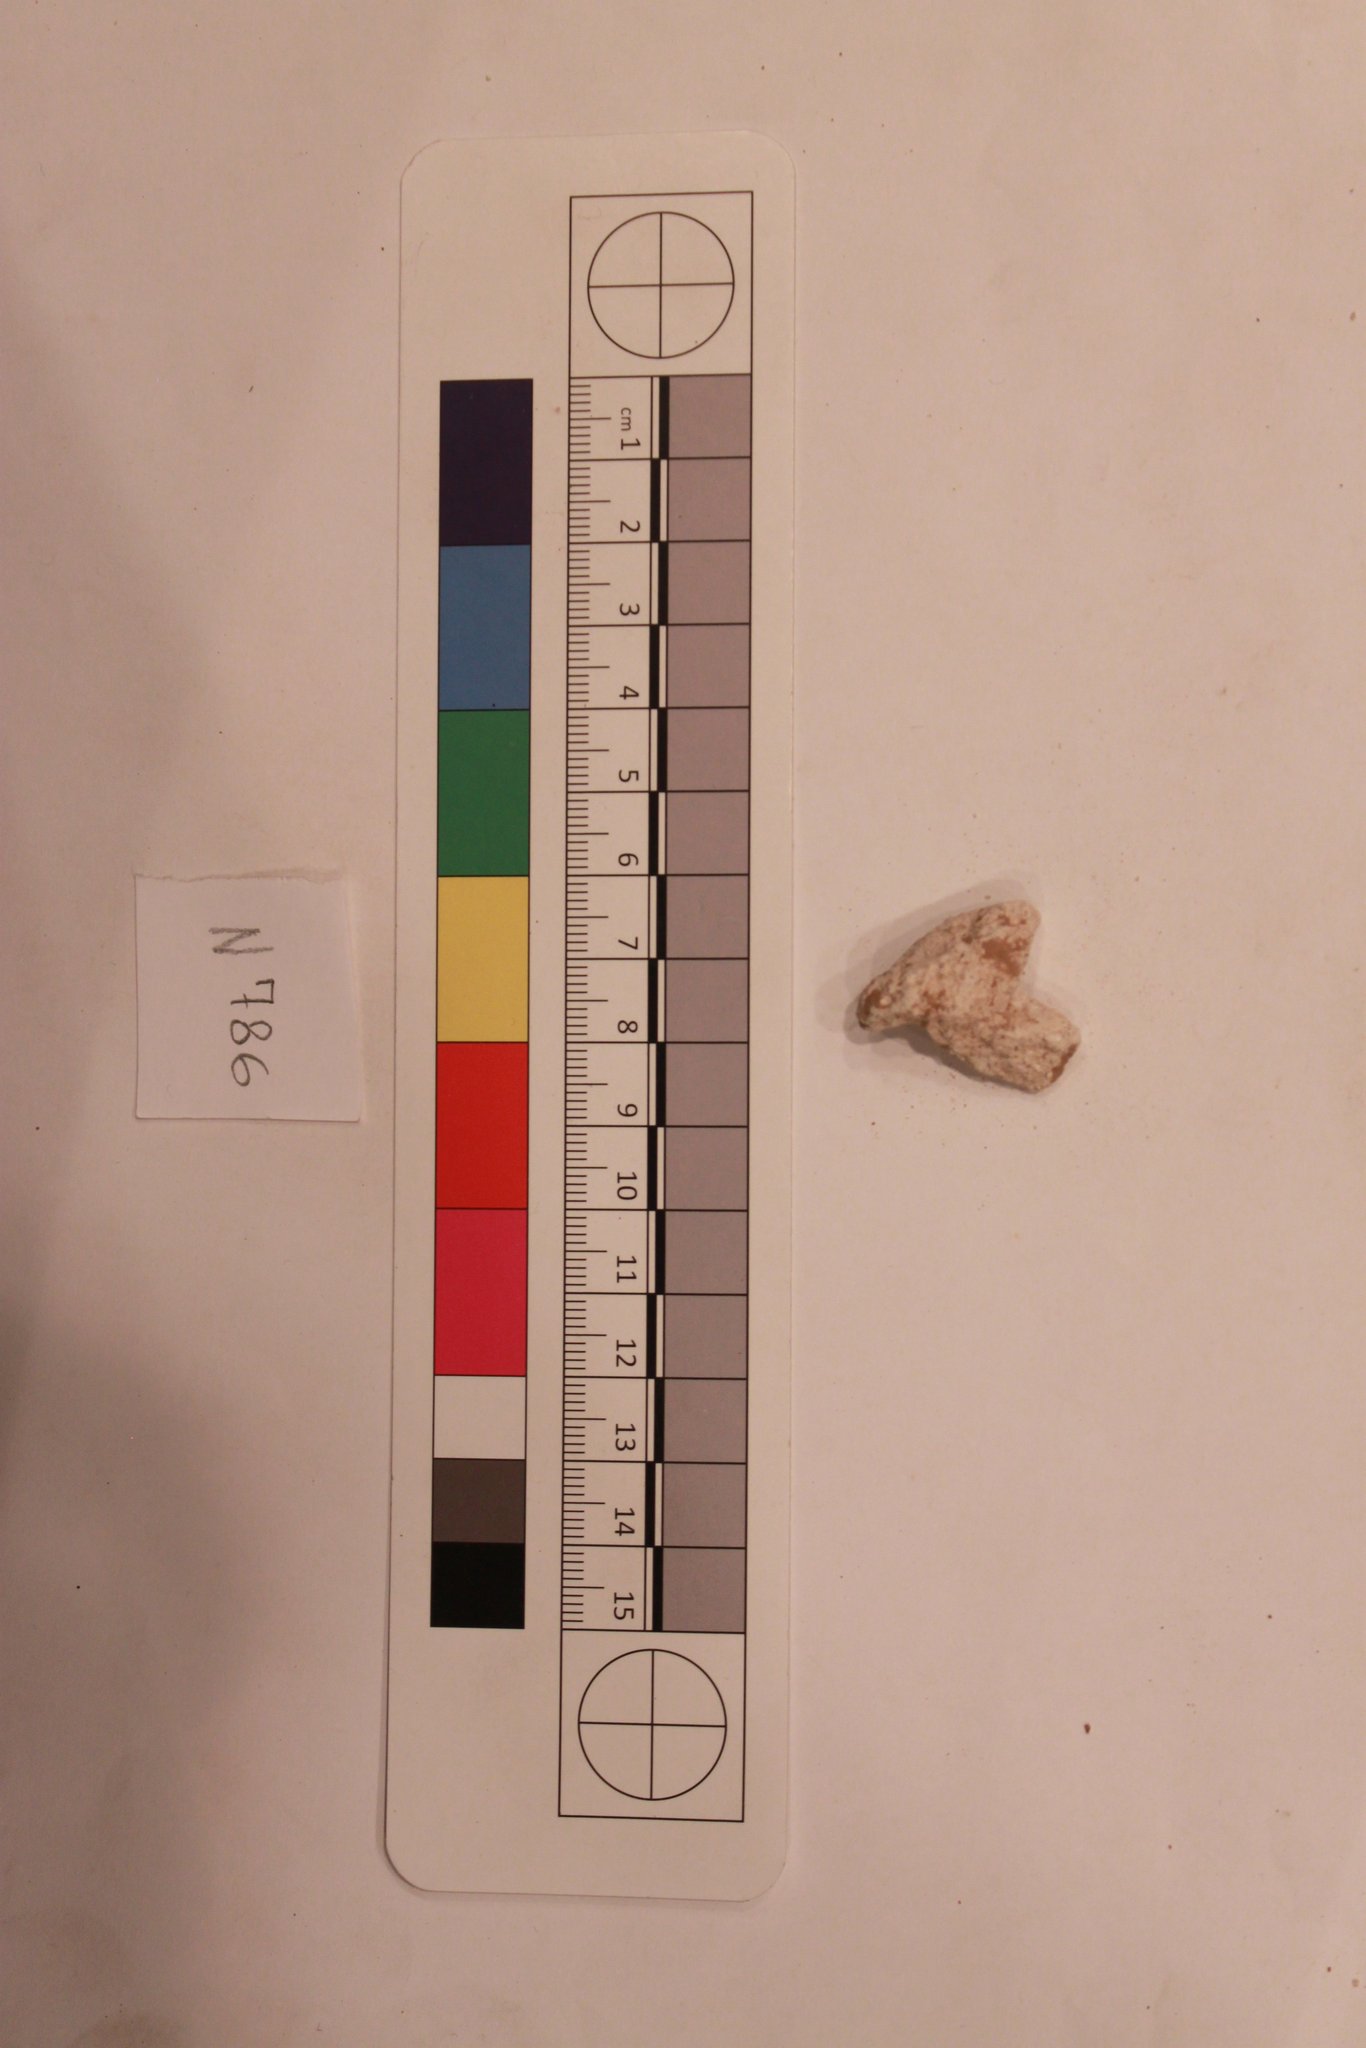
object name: fragment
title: Stucco Fragment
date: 701-1200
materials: plaster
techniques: carving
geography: iran